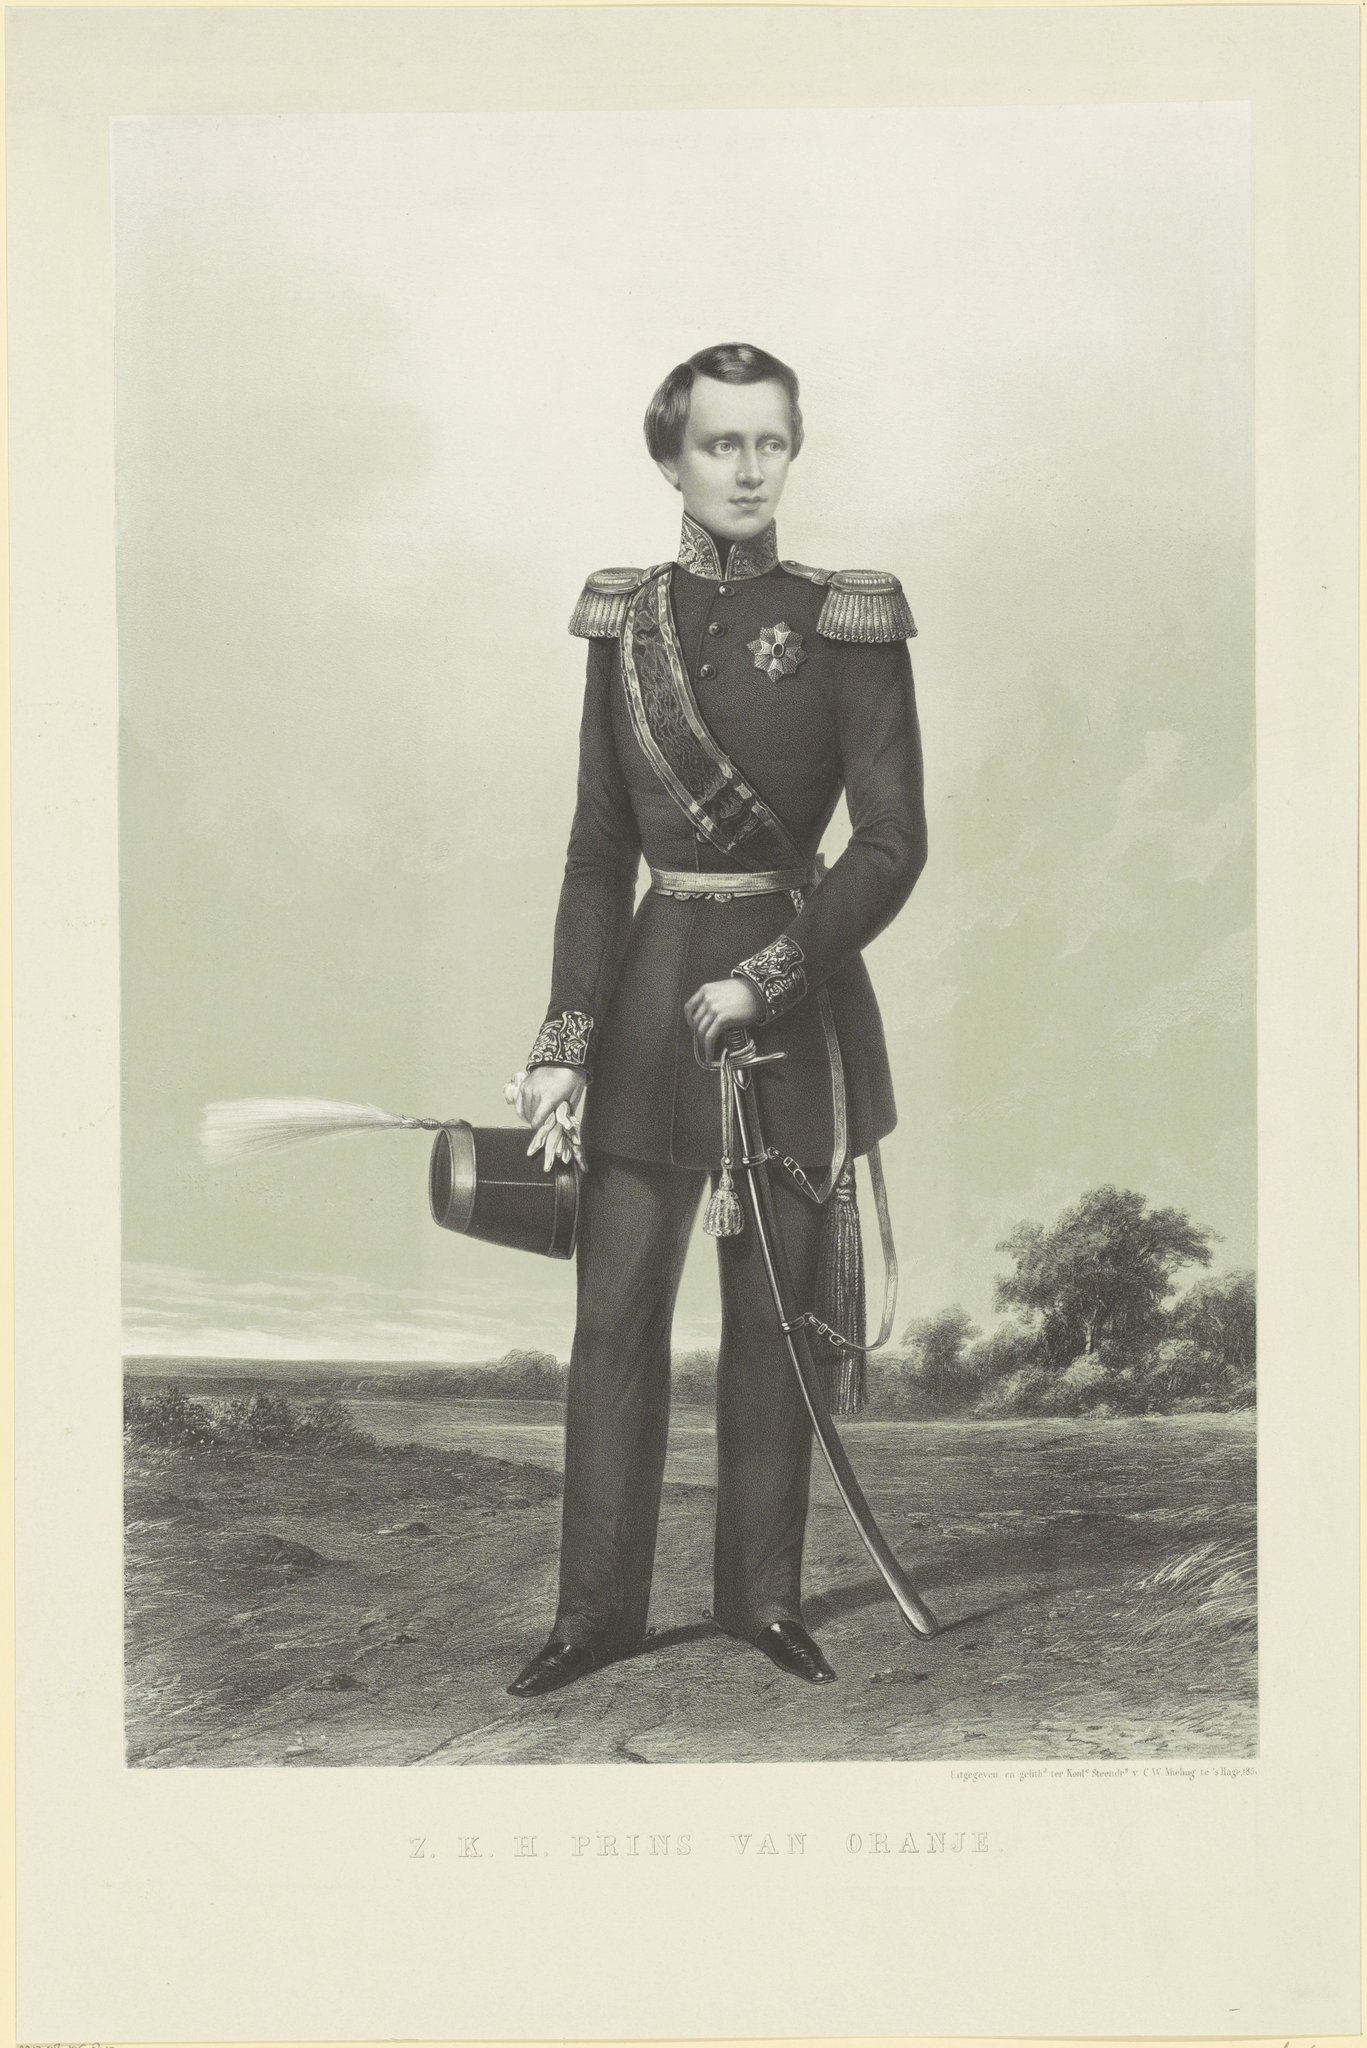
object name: print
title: Portret van Willem, prins der Nederlanden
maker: Anonymous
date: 1858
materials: paper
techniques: lithograph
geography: the hague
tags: willem (prins der nederlanden)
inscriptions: date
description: De hier vermelde titel verwijst naar de hoogst verkregen titel van de geportretteerde, niet per se naar de titel die de geportretteerde op deze voorstelling draagt.